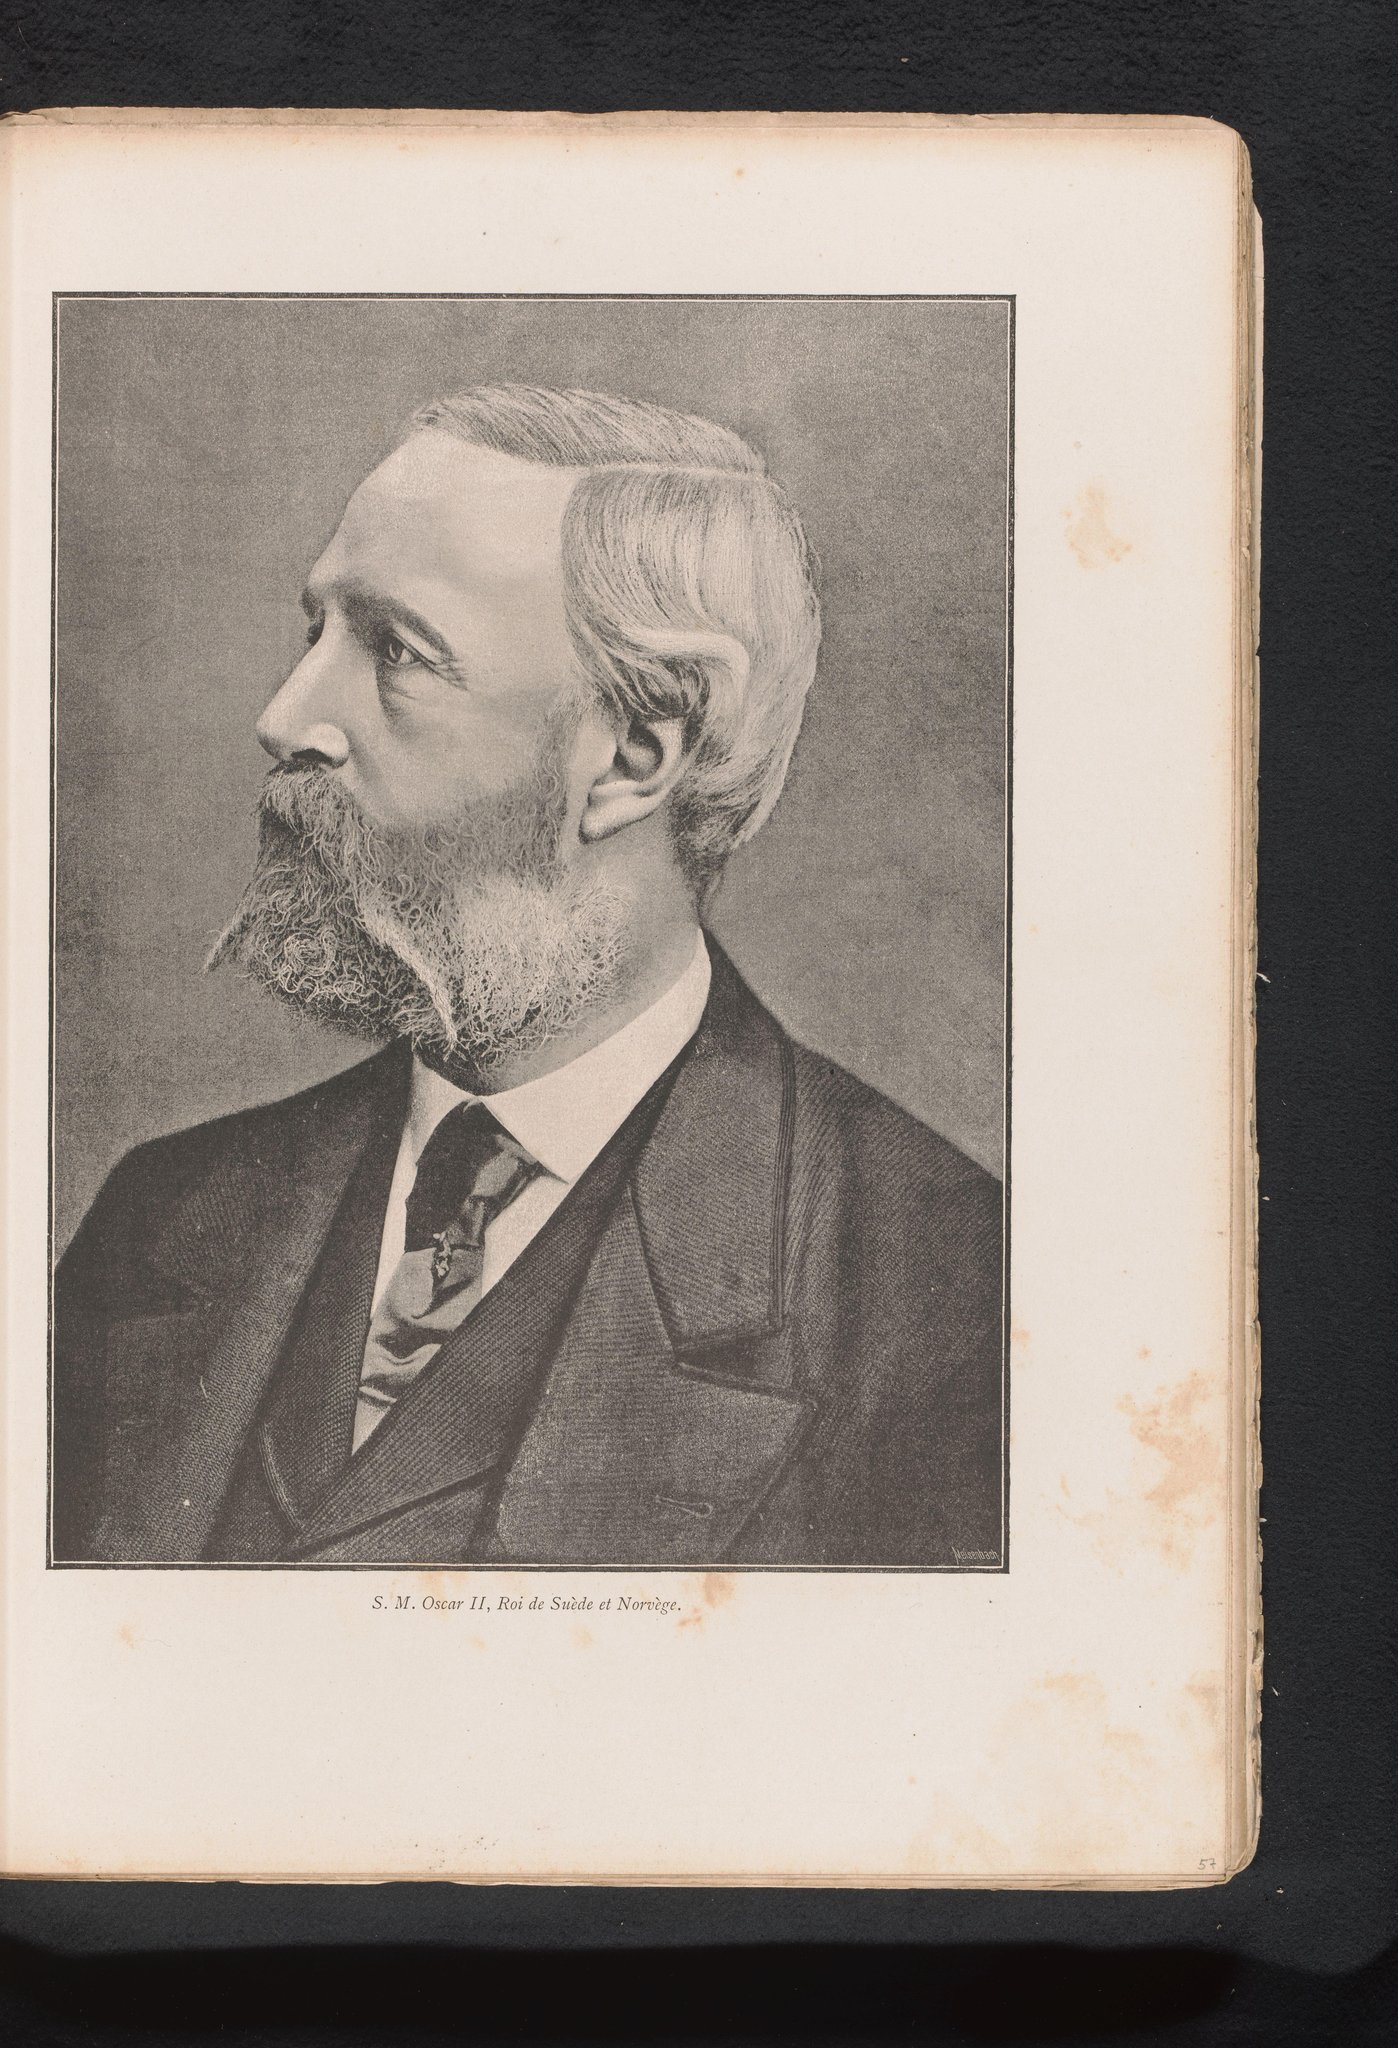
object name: photomechanical print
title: Portret van koning Oscar II van Zweden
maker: Anonymous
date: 1880-1885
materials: paper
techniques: autotype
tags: historical persons, king